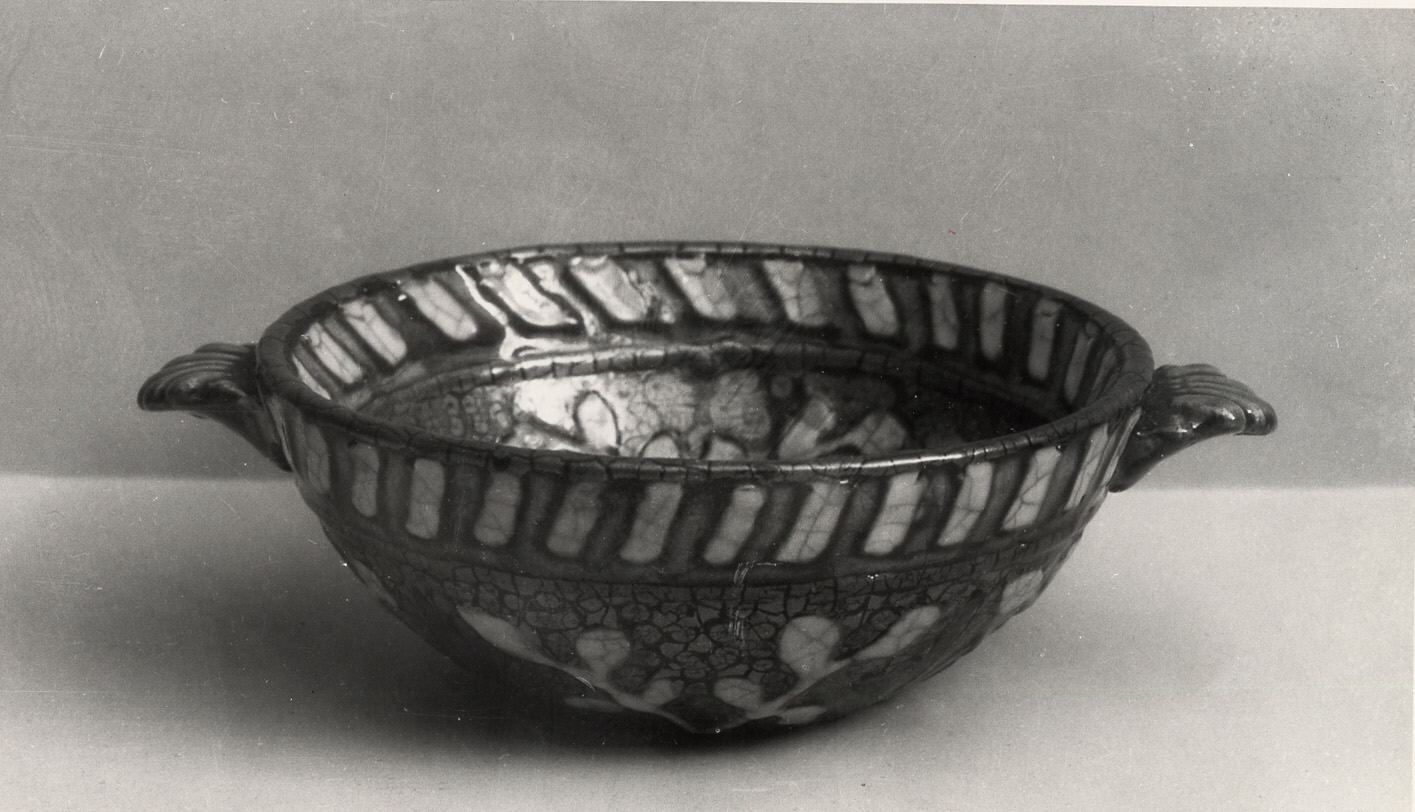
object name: bowl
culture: french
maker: andré metthey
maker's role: designer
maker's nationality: french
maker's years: 1871-1920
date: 1910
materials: earthenware